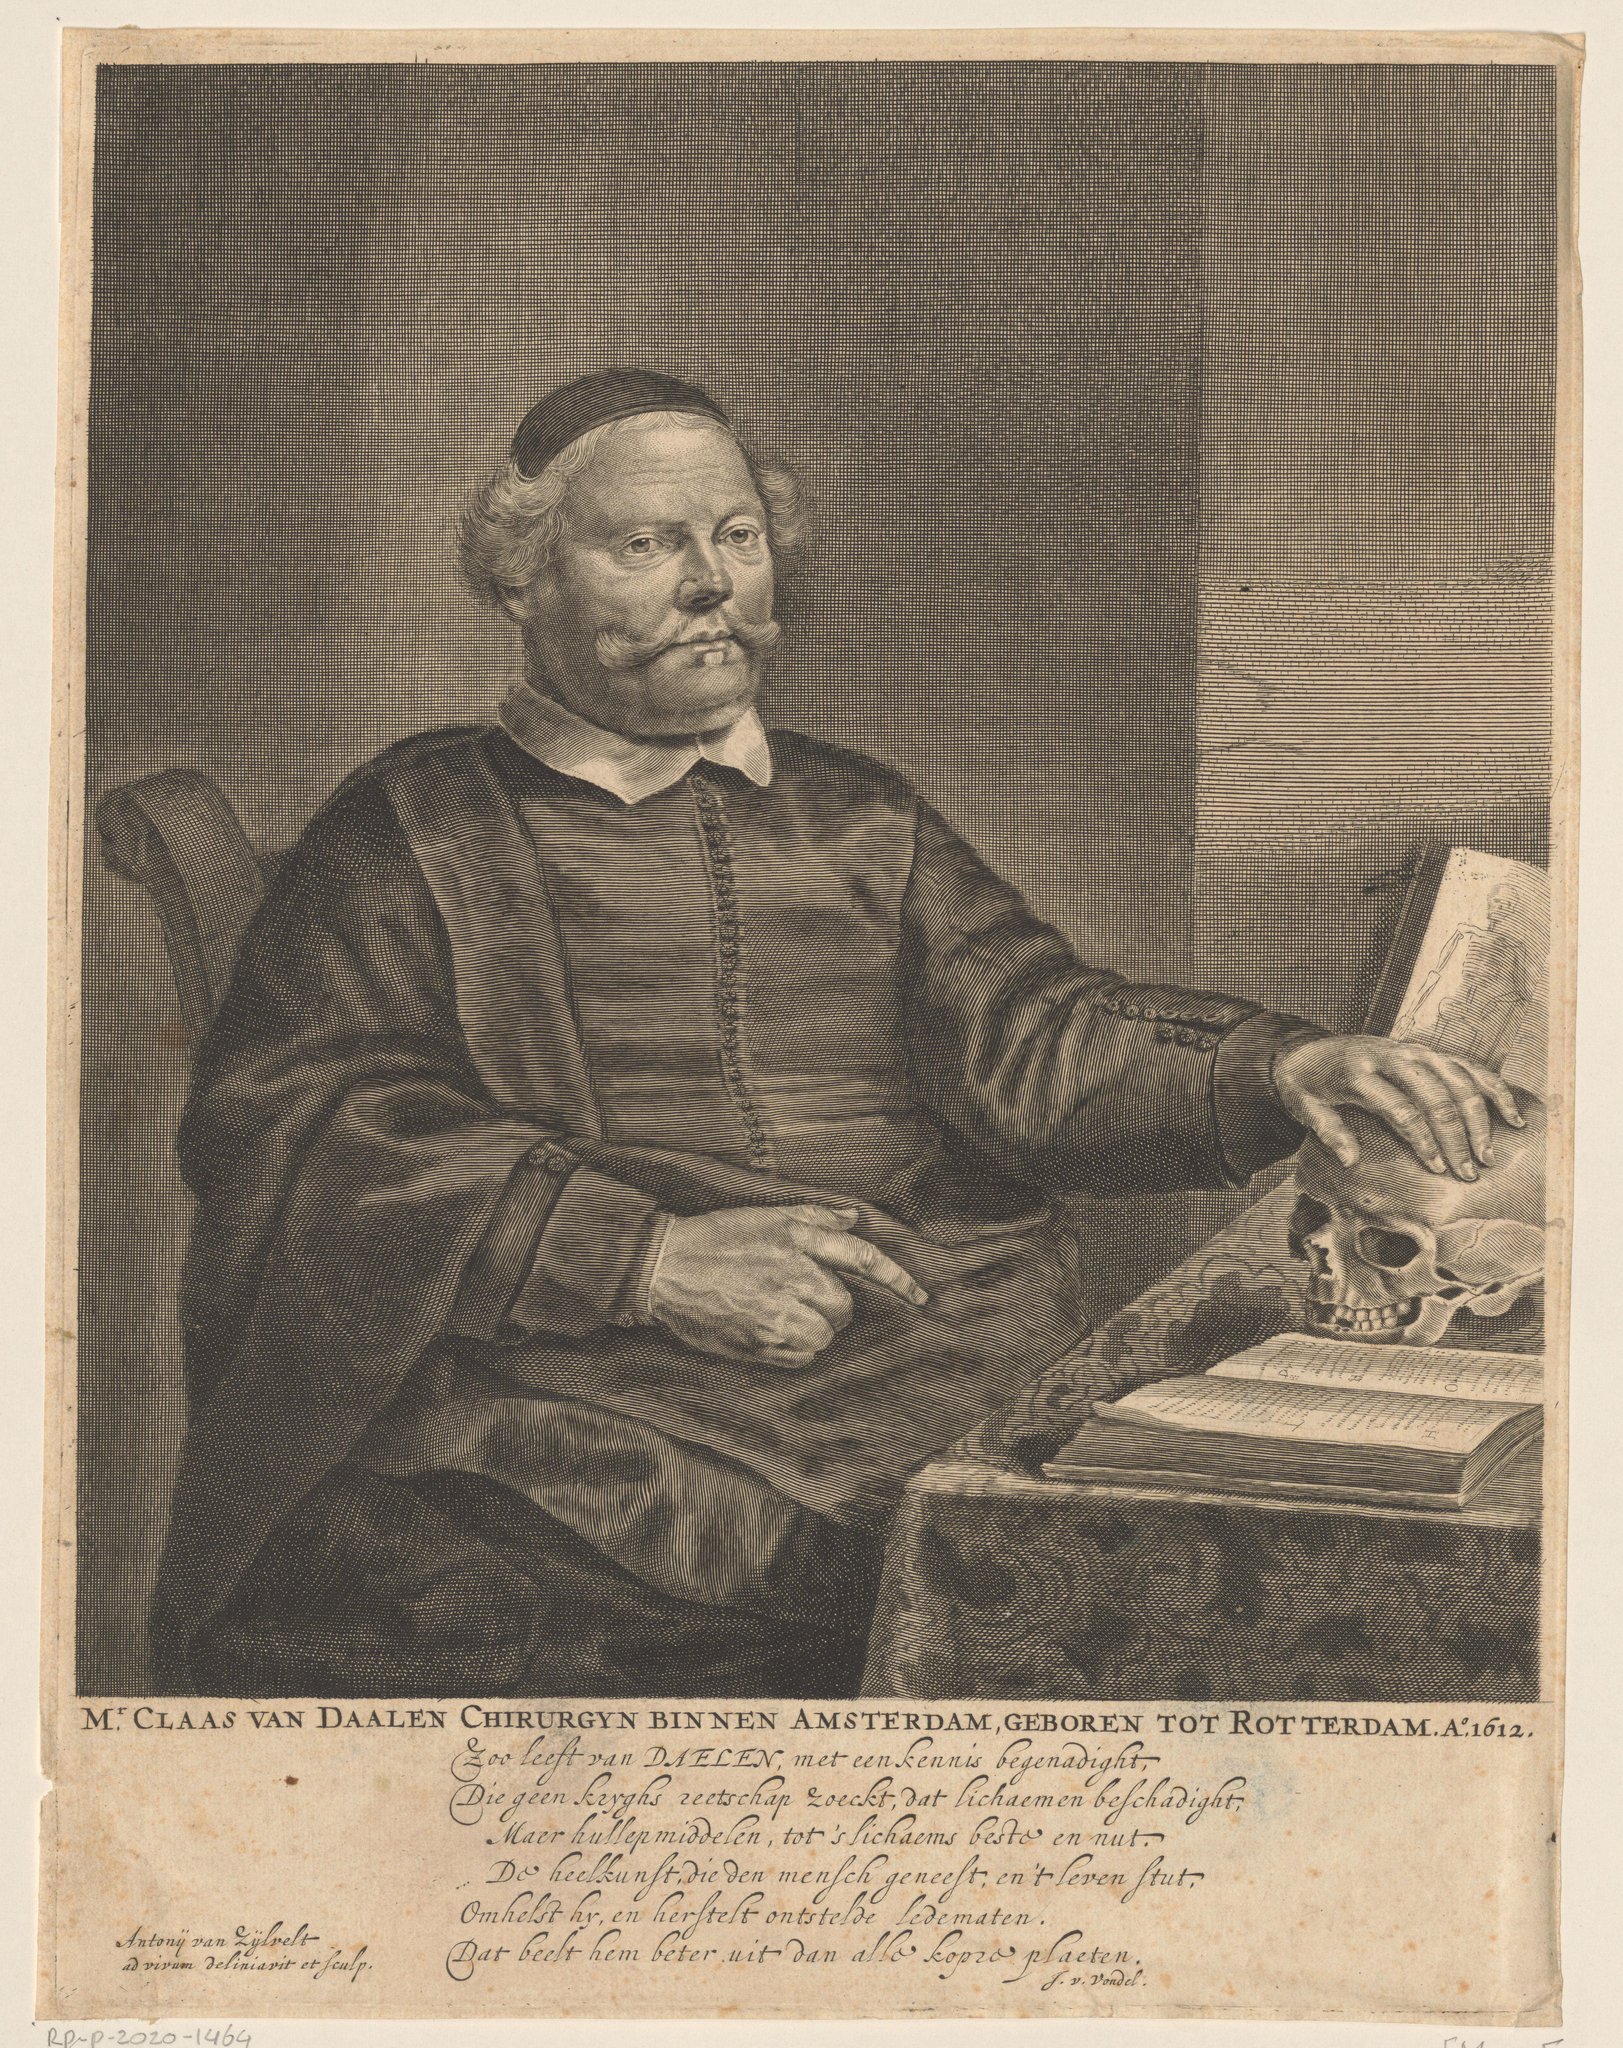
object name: print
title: Portret van chirurg Nicolaas van Daalen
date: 1656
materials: paper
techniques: engraving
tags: rotterdam, historical persons, barber; surgeon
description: Zittend aan een tafel met zijn linkerhand op een schedel. Voor hem ligt een opengeslagen boek.